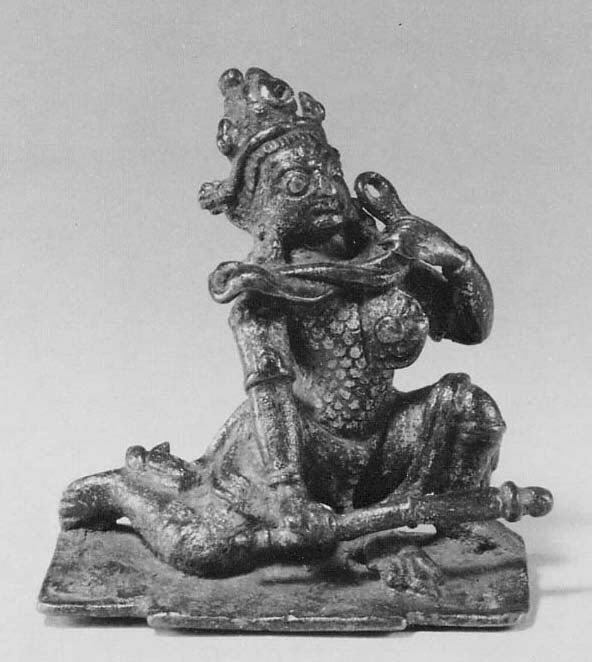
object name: figure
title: A Demon Victim of Durga's Wrath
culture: nepali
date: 1201-1300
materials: copper gilt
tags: durga,hinduism